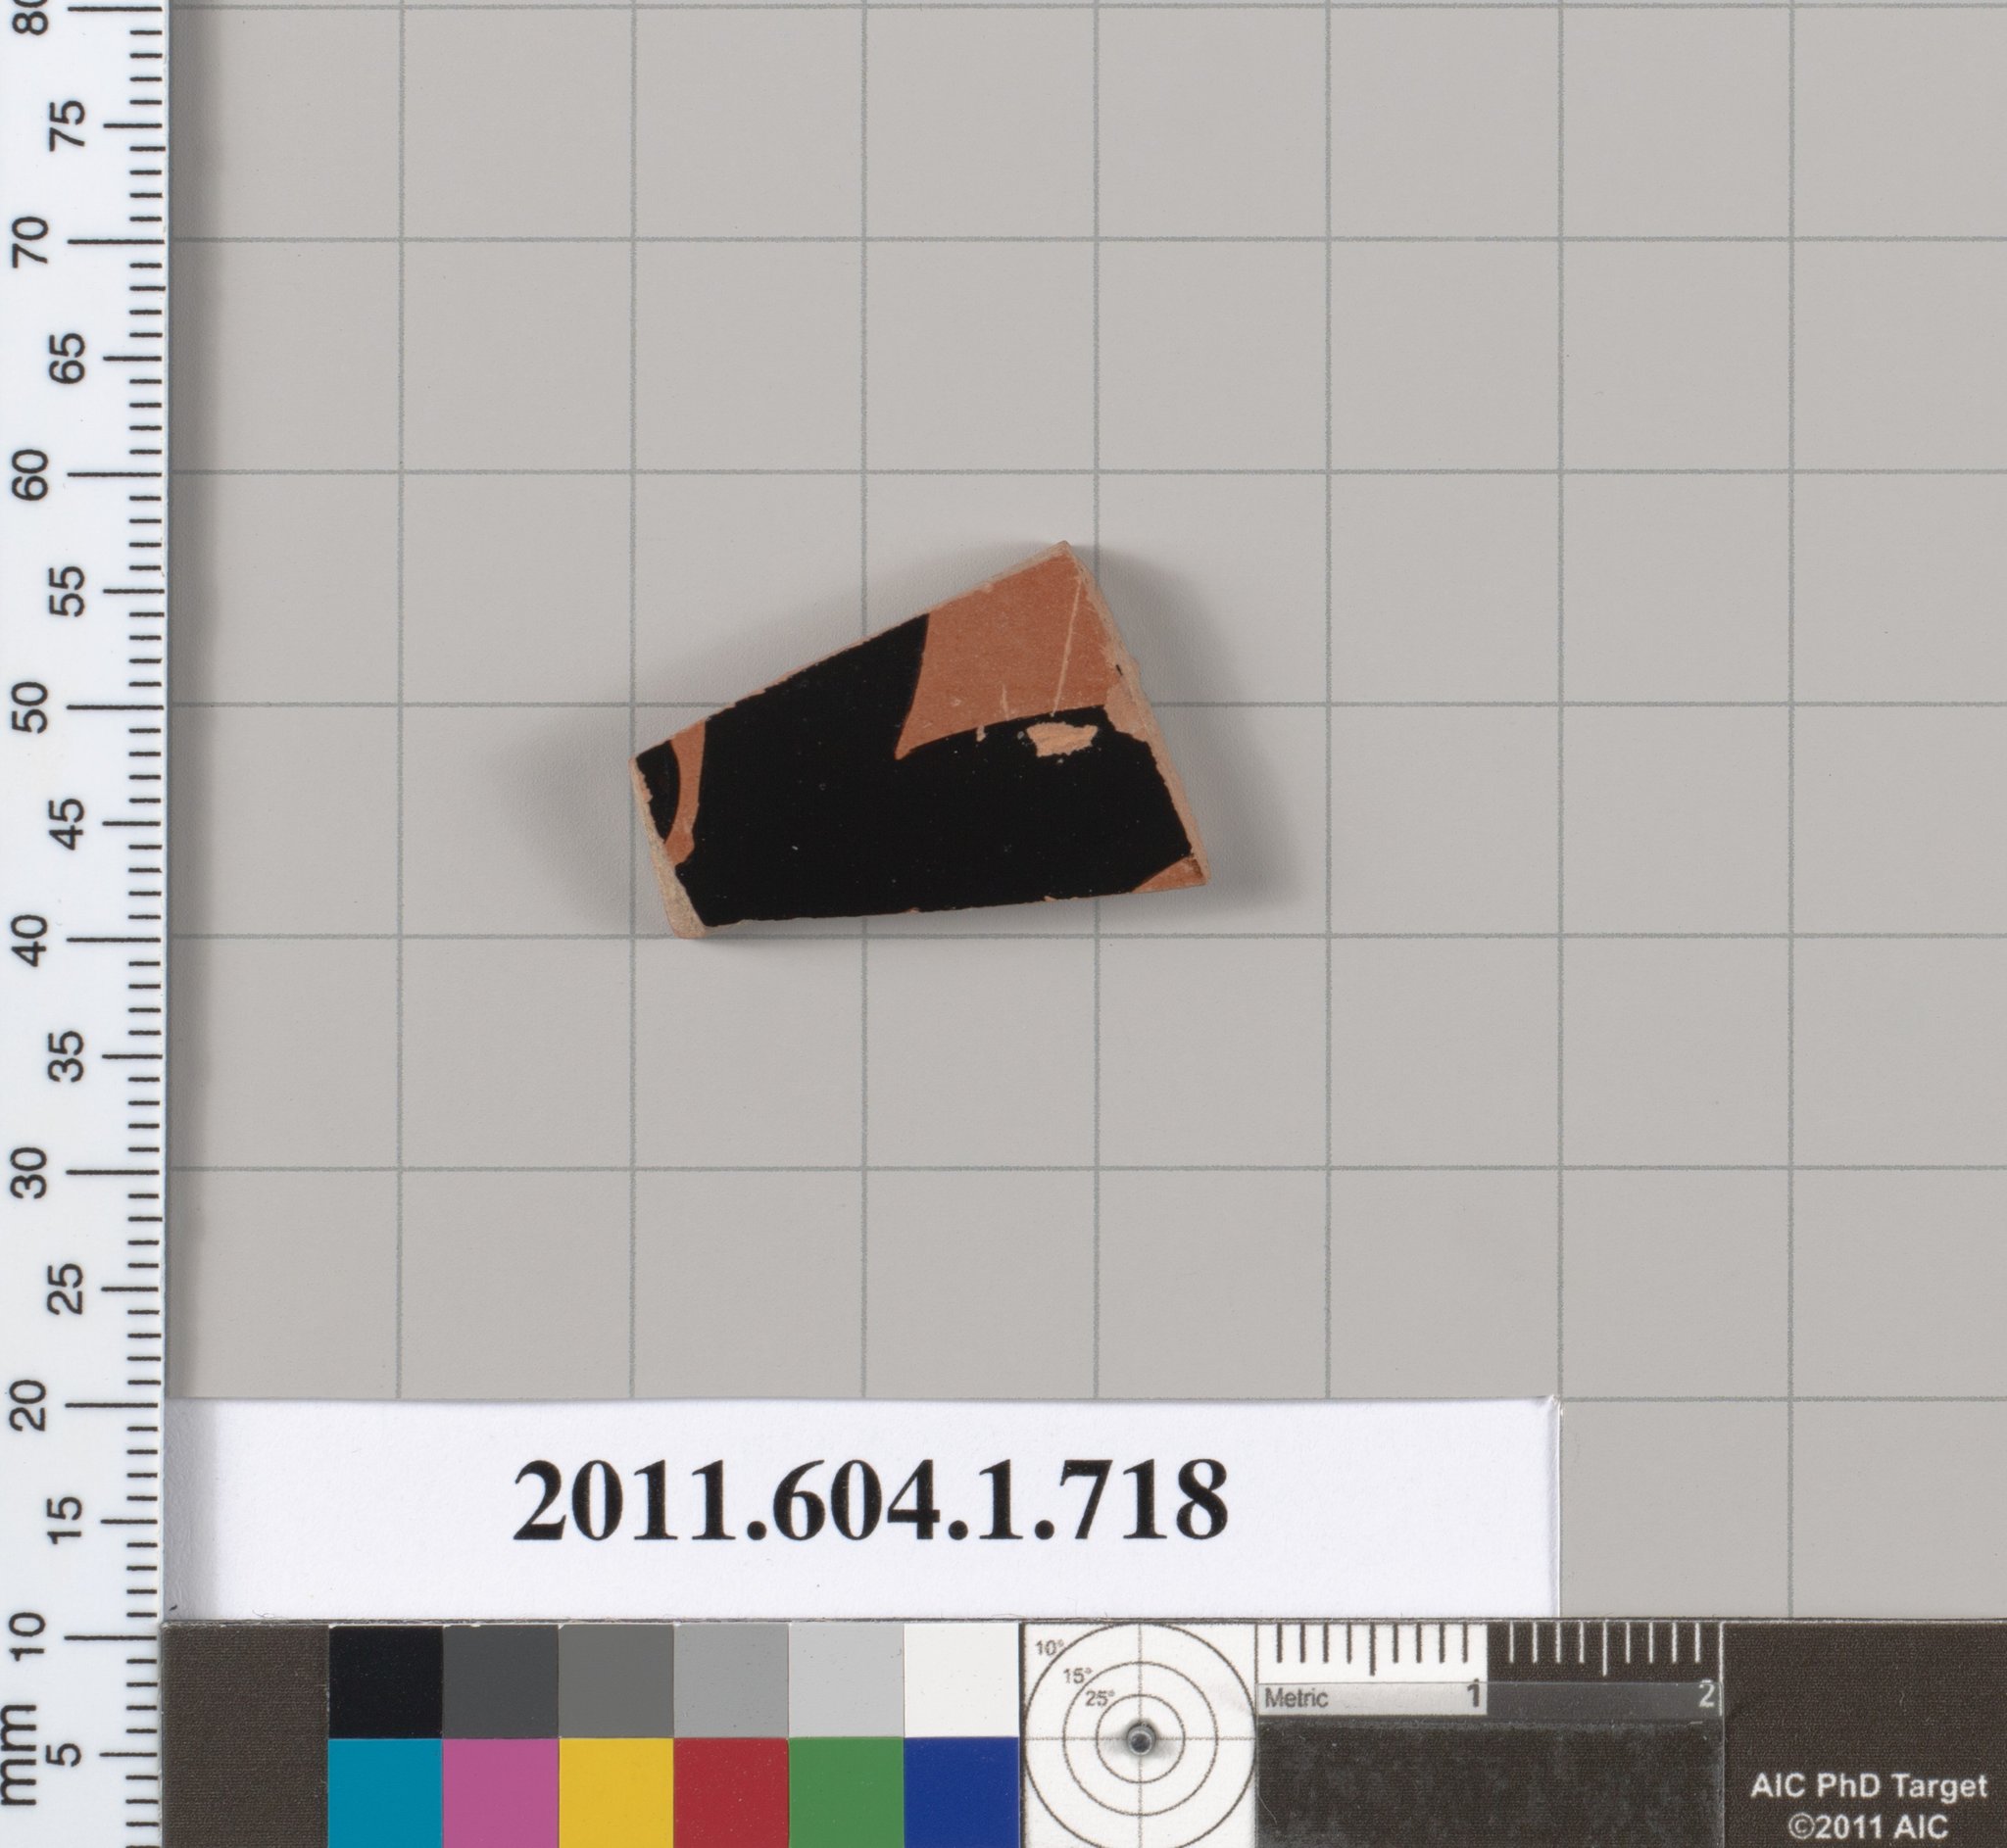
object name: kylix fragment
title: Terracotta fragment of a kylix (drinking cup)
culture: greek, attic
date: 475-451 BCE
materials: terracotta